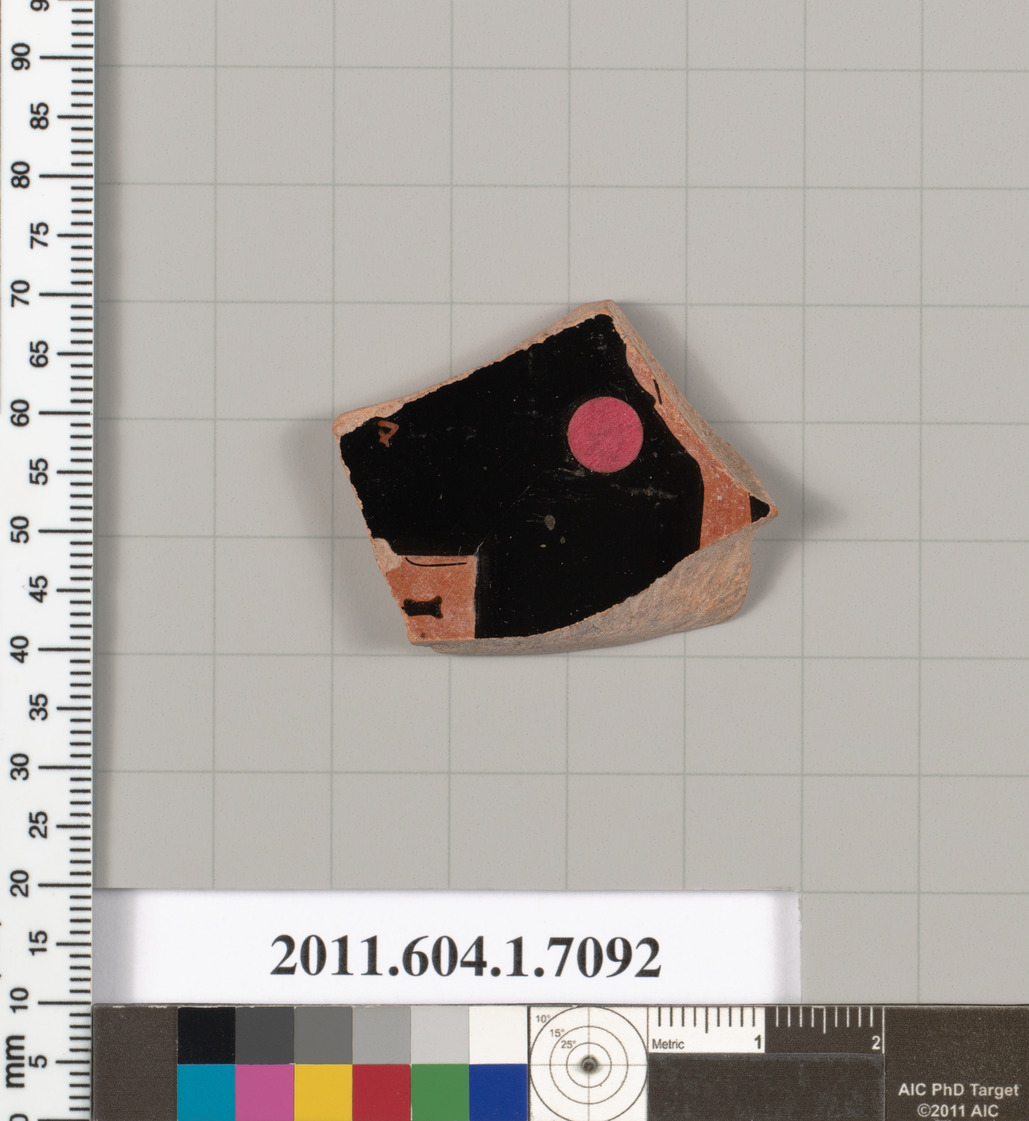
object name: kylix fragment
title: Terracotta fragment of a kylix (drinking cup)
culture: greek, attic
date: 500-480 BCE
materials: terracotta